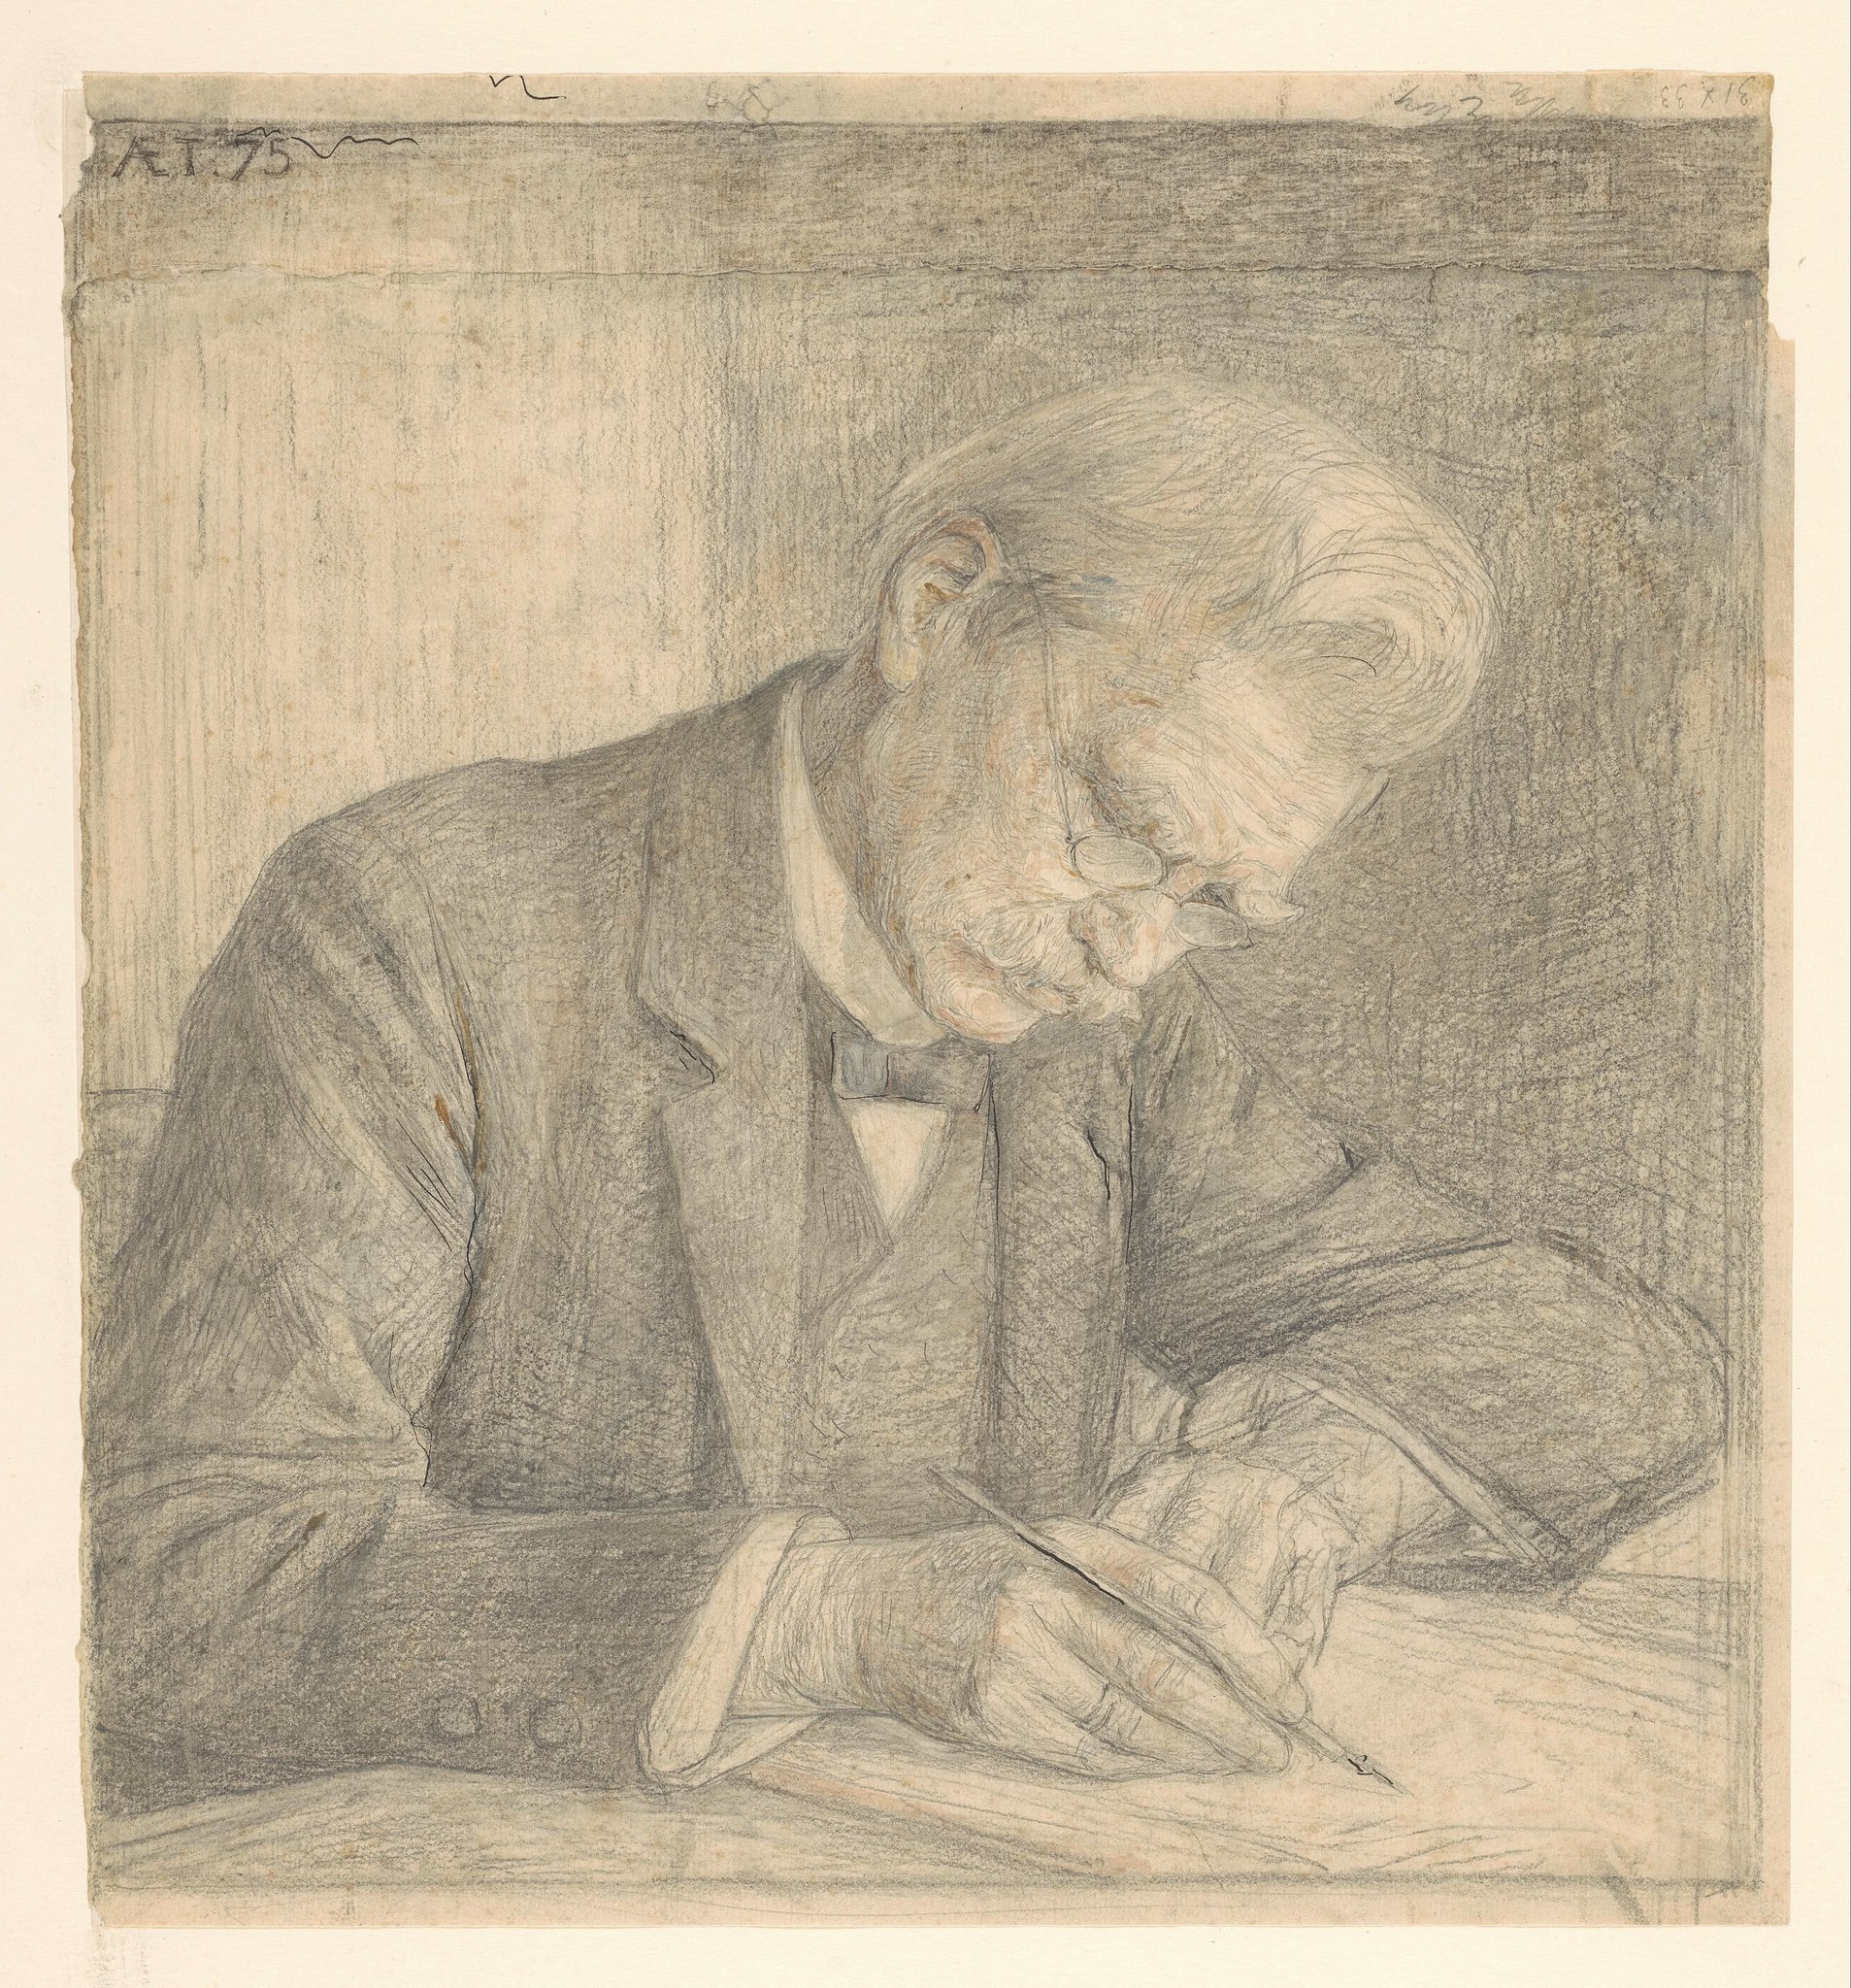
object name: drawing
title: Portret van J. van der Vegt, schrijvend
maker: jan veth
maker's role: designer, draughtsman, painter, print maker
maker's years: 1864-1925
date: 1874-1925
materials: chalk, ink, paper, pencil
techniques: brush, pen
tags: historical persons